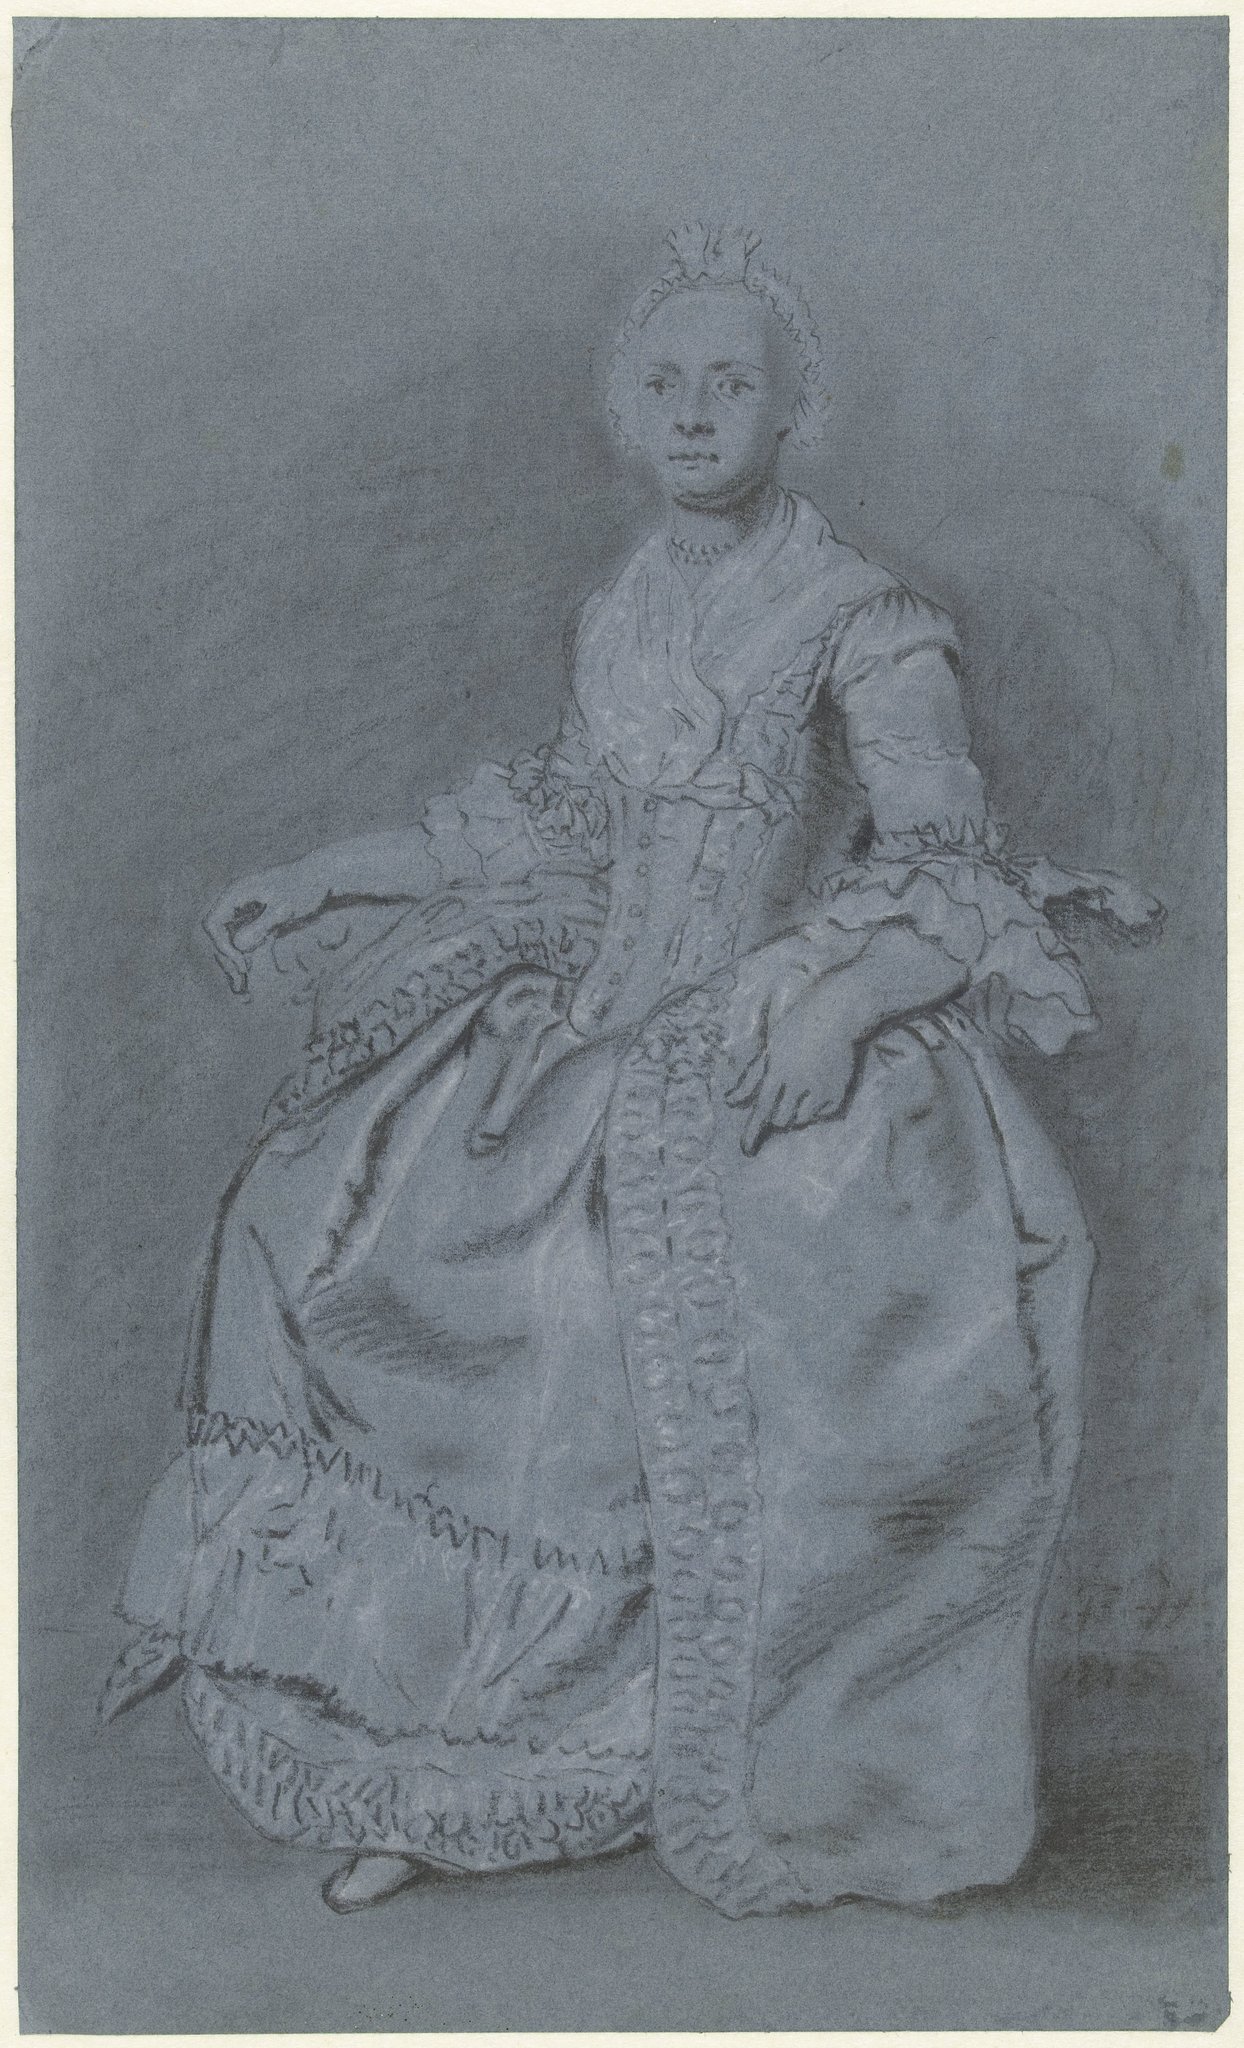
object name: drawing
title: Voorstudie voor het portret van Maria Croon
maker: jordanus hoorn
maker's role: draughtsman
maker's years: 1753-1833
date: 1763-1833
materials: chalk, paper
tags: historical persons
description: Voorstudie voor het portret van Maria Croon, voor het portret van het gezin van Gerrit Willem van Oosten de Bruyn.